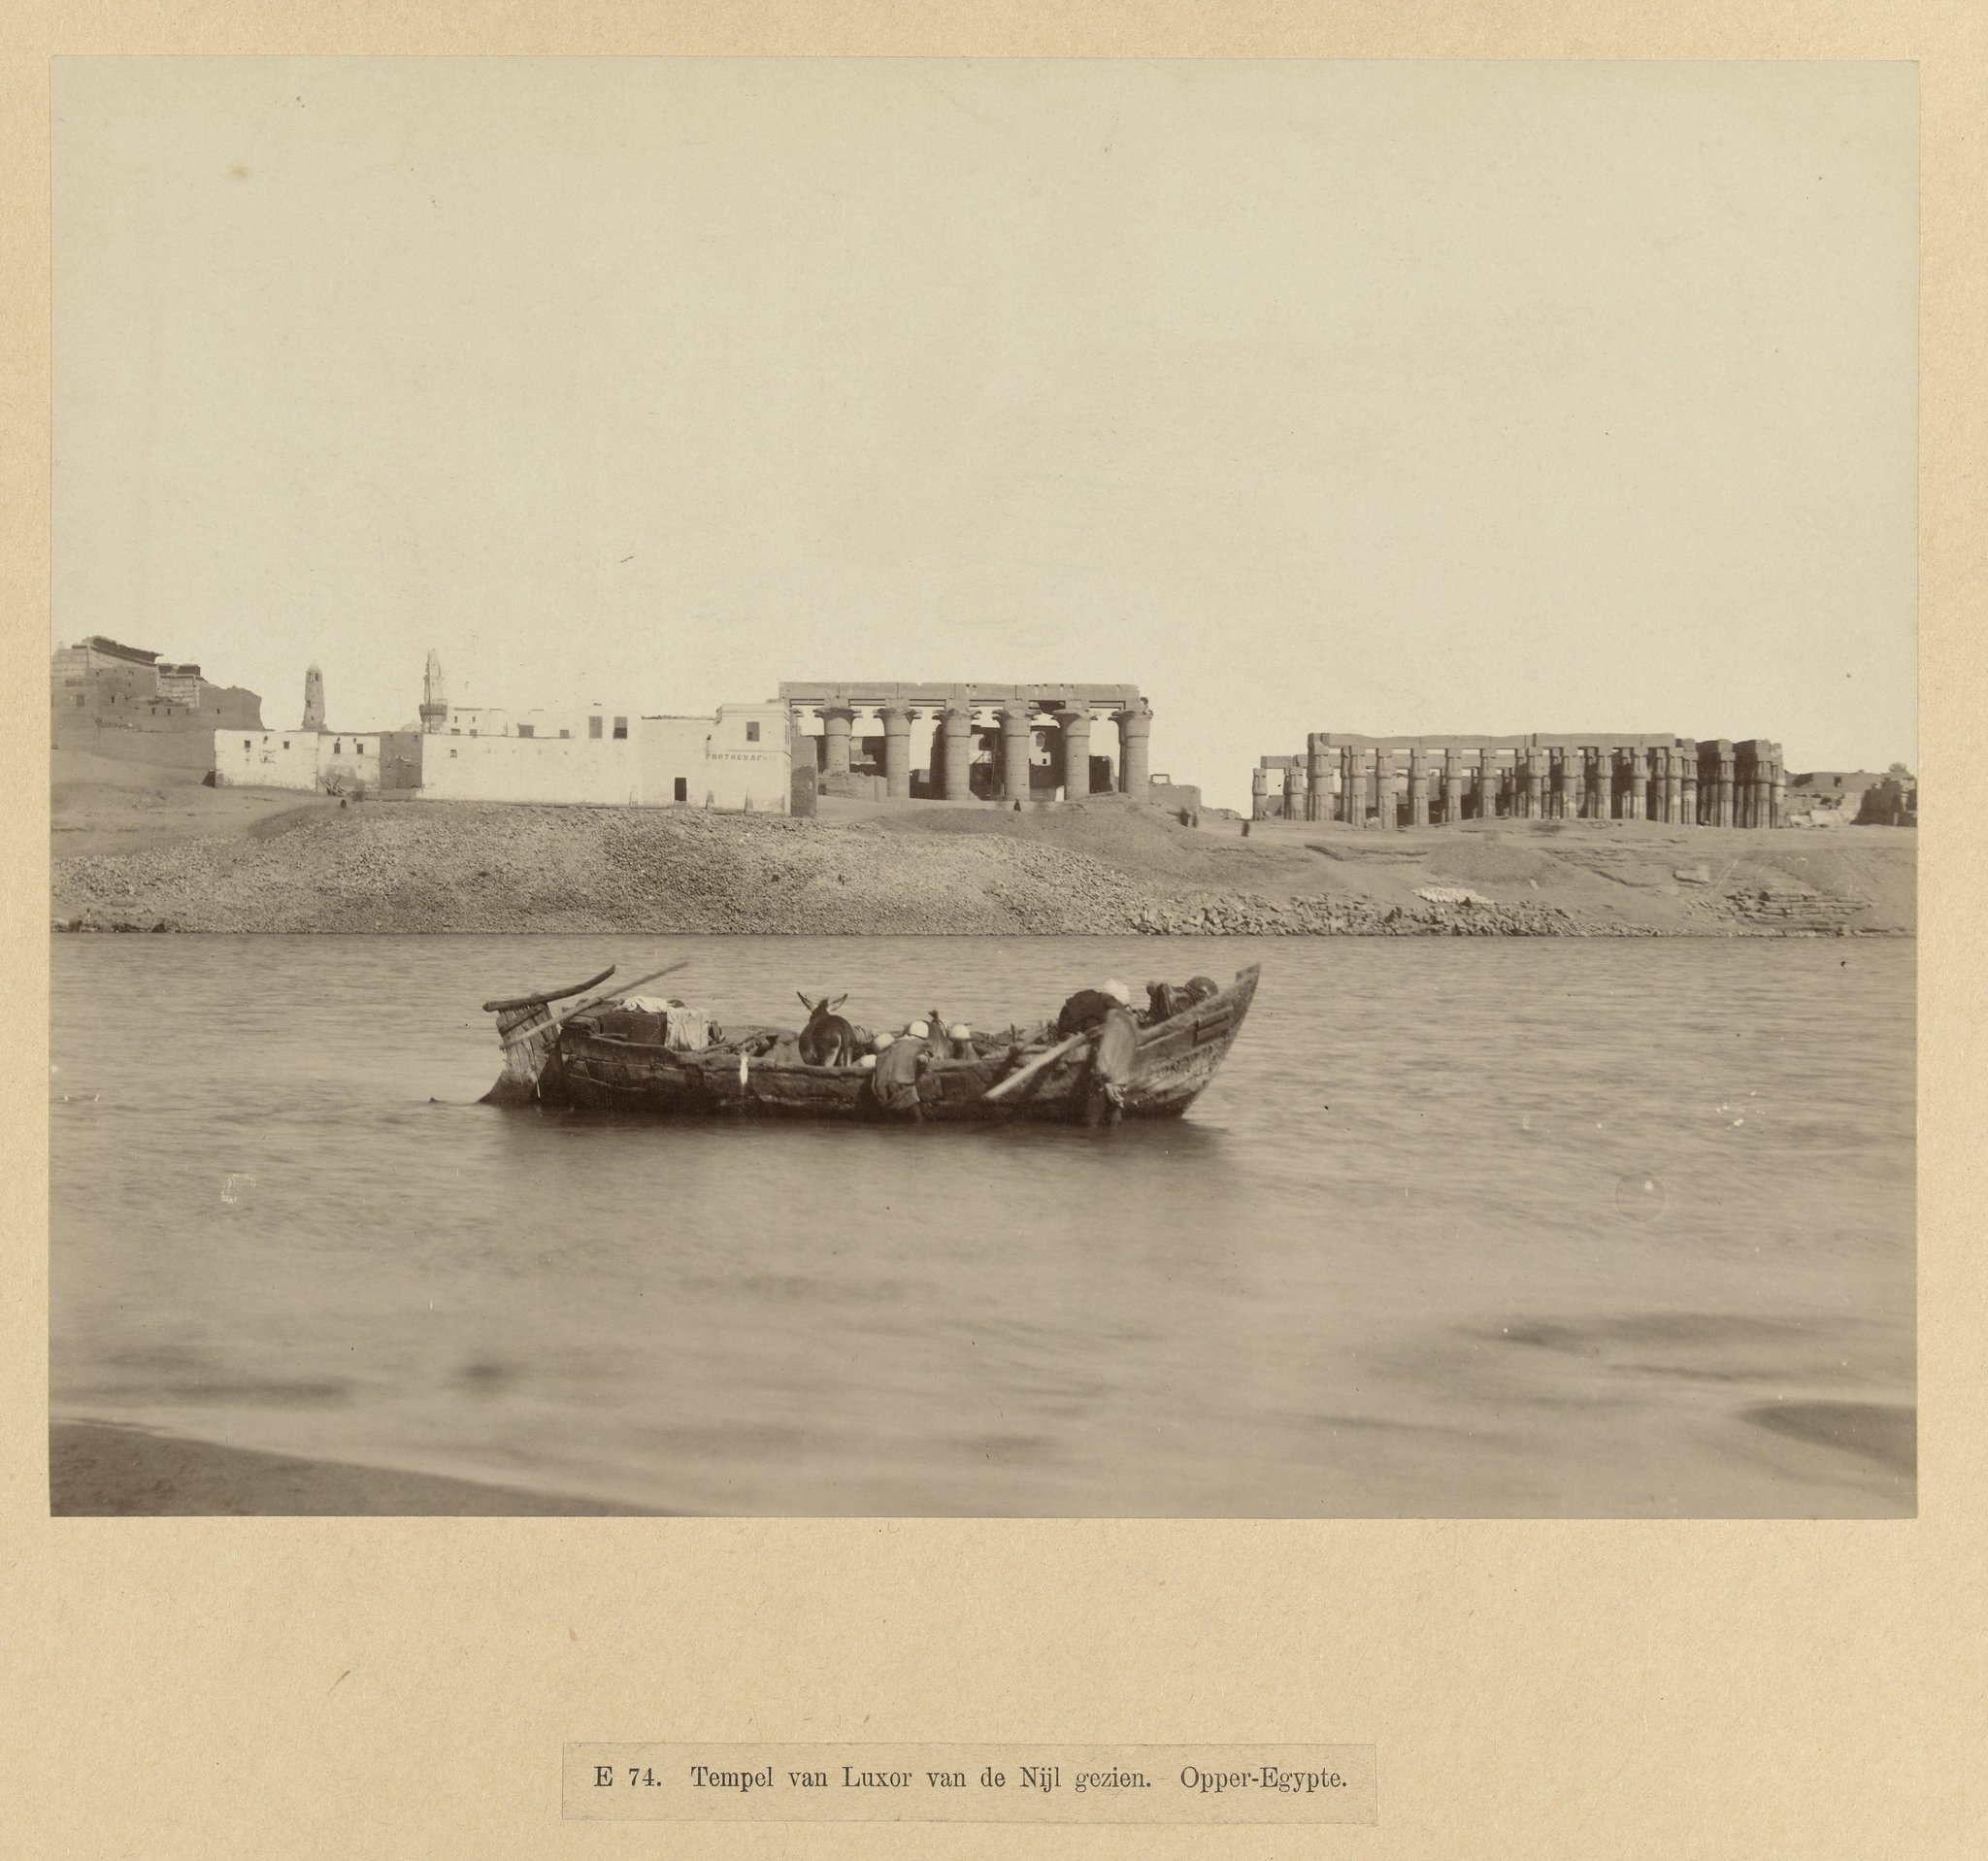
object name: photograph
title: Tempel van Luxor gezien vanaf de Nijl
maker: antonio beato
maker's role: fotograaf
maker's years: 1835-1906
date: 1862-1895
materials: cardboard, paper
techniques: albumen print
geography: luxor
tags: temple, shrine ~ egyptian religion, river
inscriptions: stamp: ‘GEMEENTELIJKE BIBLIOTHEEK/ ROTTERDAM’, title: ‘E 74. Tempel van Luxor van de Nijl gezien. Opper-Egypte.’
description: Onderdeel van een groep door fotograaf Richard Polak op reis verzamelde foto’s. Deze foto is samen met andere op zijn reizen verzamelde foto's tentoongesteld bij de Rotterdamsche Kunstkring (1895), Arti en Amicitiae te Amsterdam (1897-1898?) en Societeit 't Collegie te Kampen (datum vooralsnog onbekend).